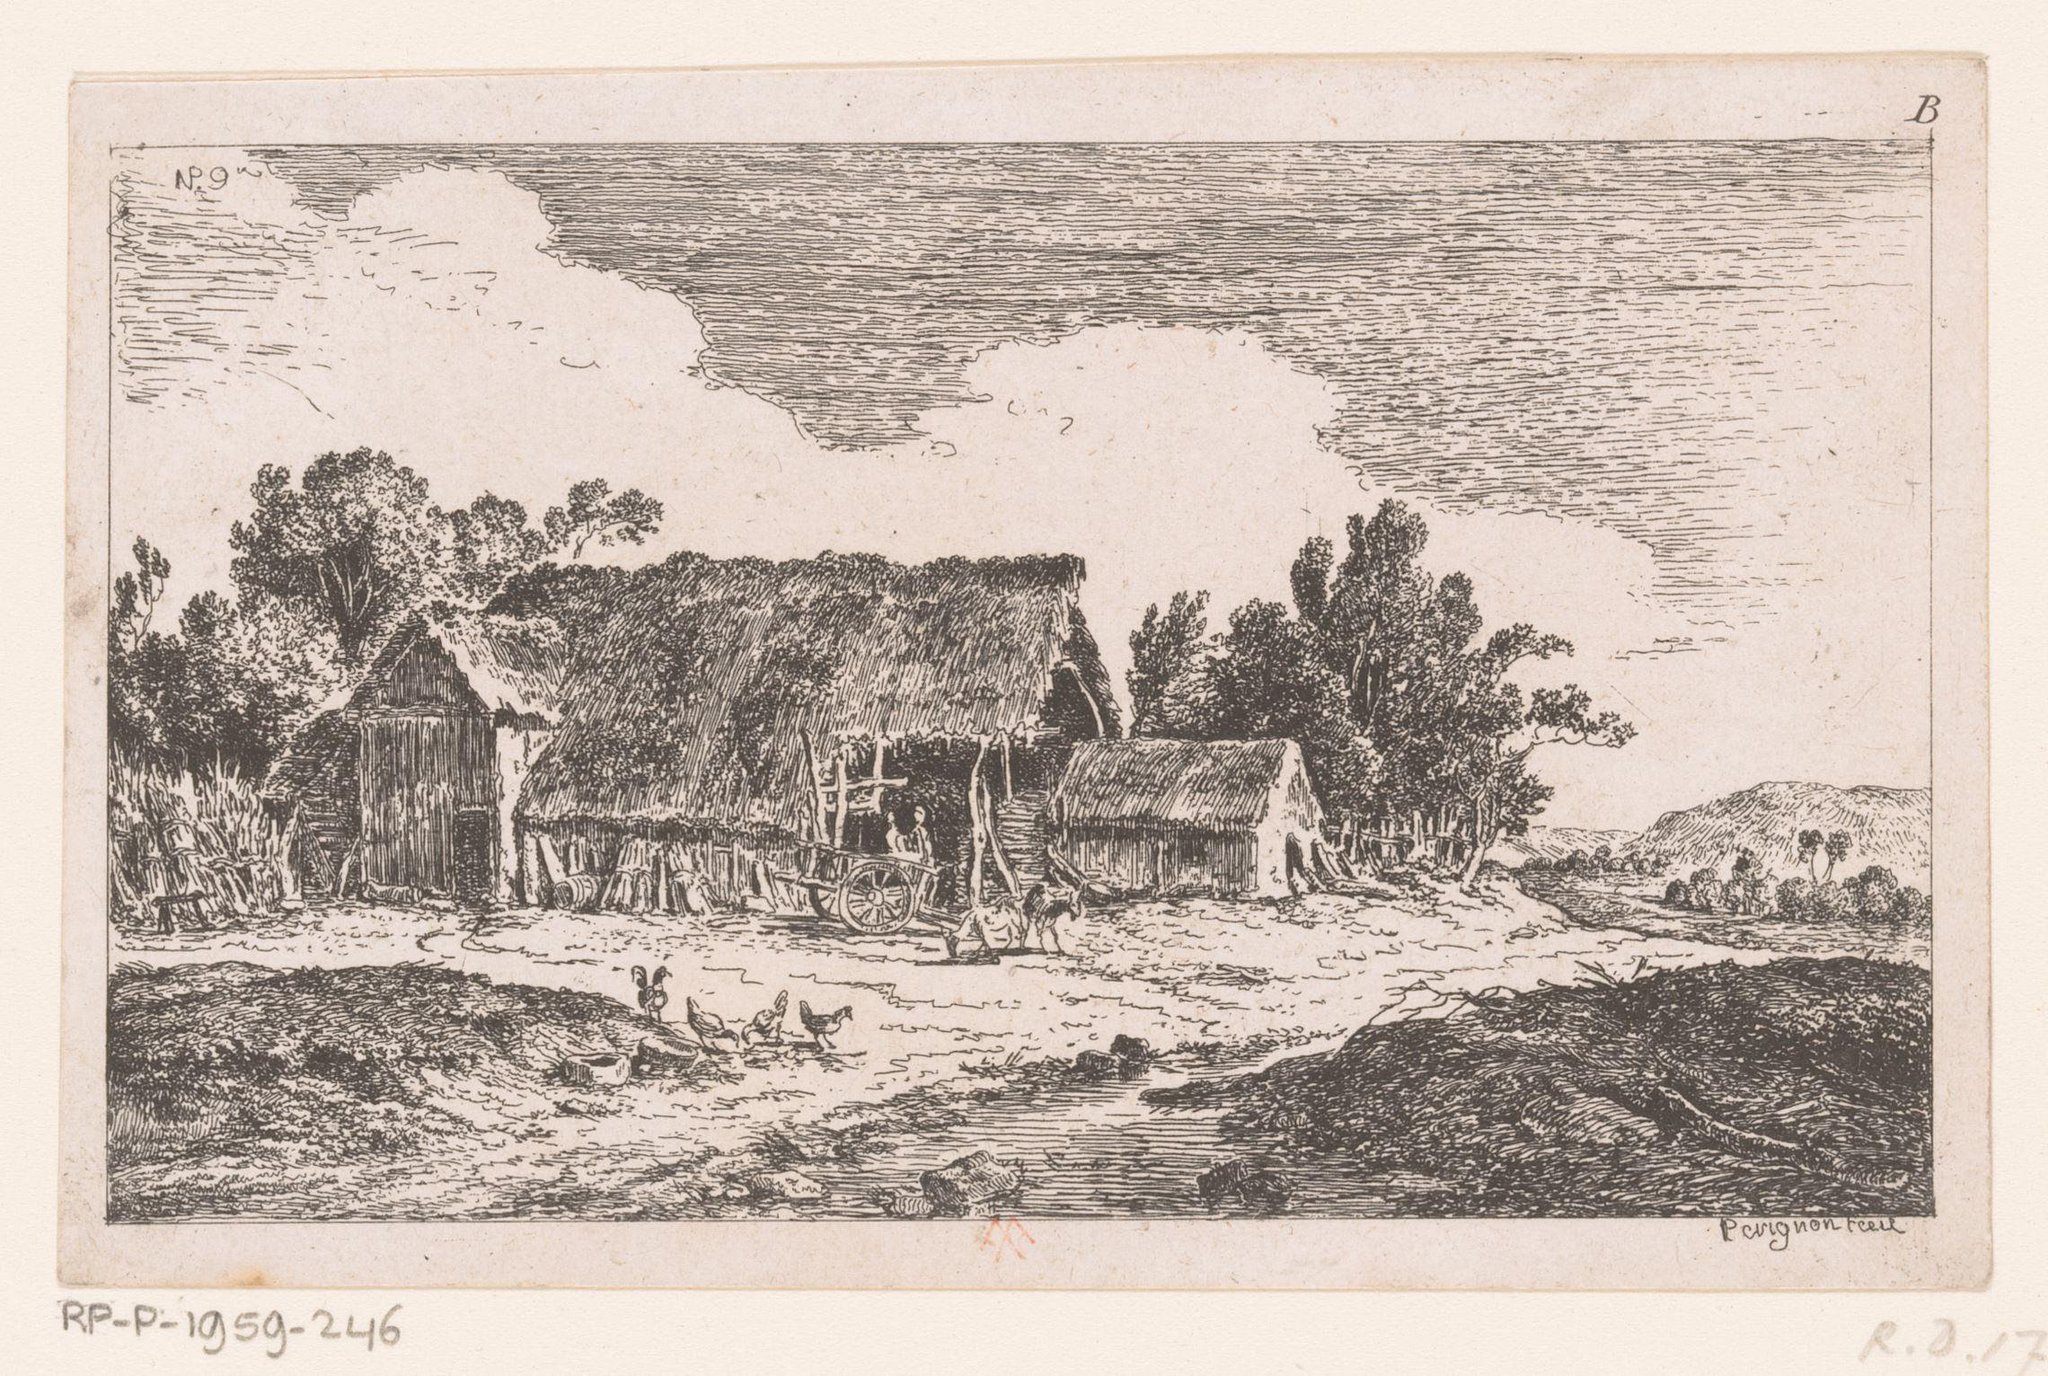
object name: print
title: Boerderij met kippen en geiten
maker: alexis nicolas pérignon (le vieux)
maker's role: draughtsman, print maker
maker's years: 1726-1782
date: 1768-1772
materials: paper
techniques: etching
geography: paris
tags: fowl (cock, hen, chicken, etc.), farm or solitary house in landscape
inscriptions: collector's mark: Lugt 60, collector's mark: Lugt 2228, collector's mark: Lugt 2760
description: Tussen 1768 en 1772 publiceerde Pérignon zes Cahiers de Paysage, met elk zes prenten. Deze prent maakt deel uit van het tweede Cahier.